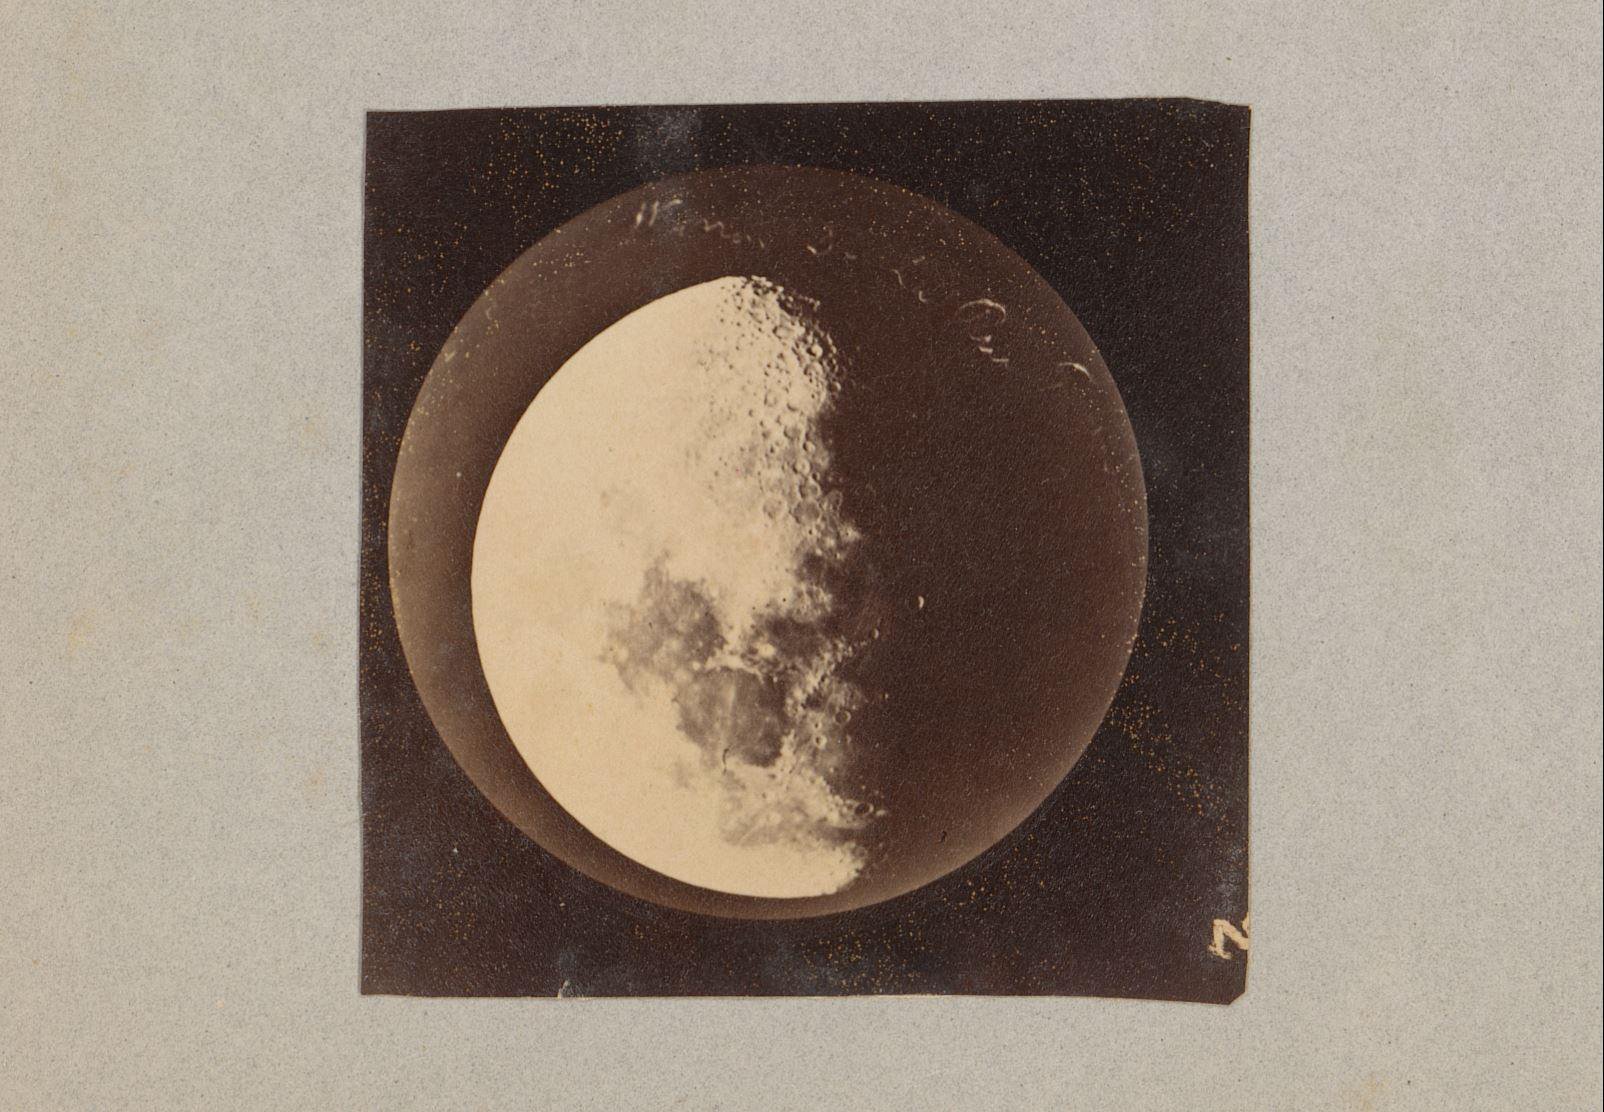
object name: reproduction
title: Fotoreproductie van foto door Warren de la Rue van vlekken op de maan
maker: marinus pieter filbri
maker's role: instrument maker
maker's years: 1852-1917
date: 1887-1888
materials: paper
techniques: albumen print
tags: surface of the moon, moon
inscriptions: inscription: ‘Vlekken op de maan/ naar phot.’